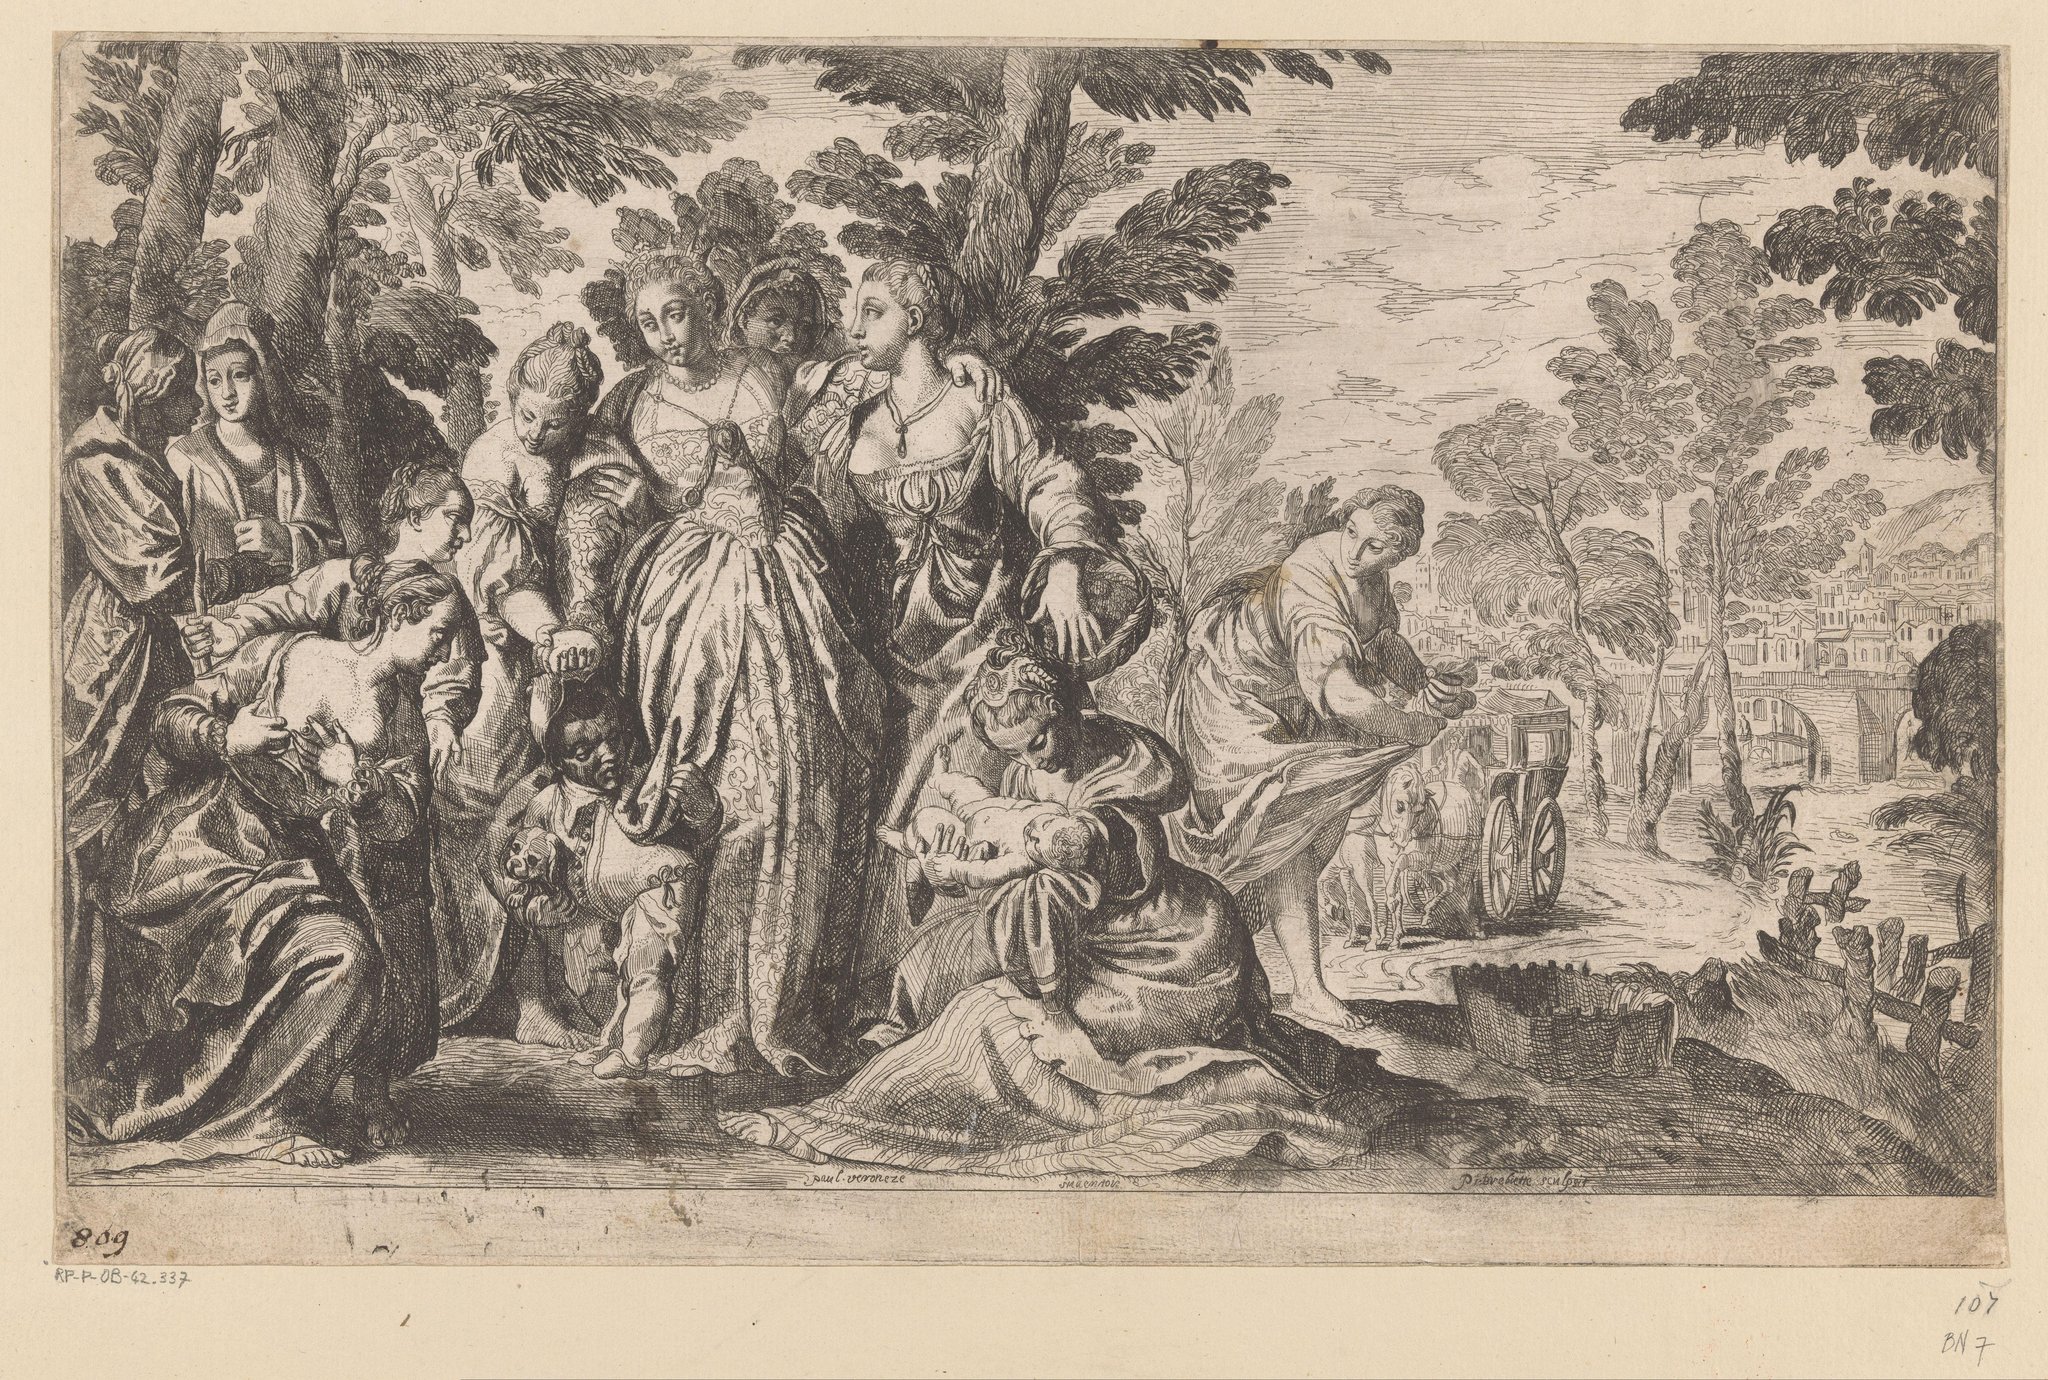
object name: print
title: Mozes wordt gevonden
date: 1608-1650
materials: paper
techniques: etching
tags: moses is pulled out of the water by the servants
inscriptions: number: ‘240’, collector's mark: Lugt 240